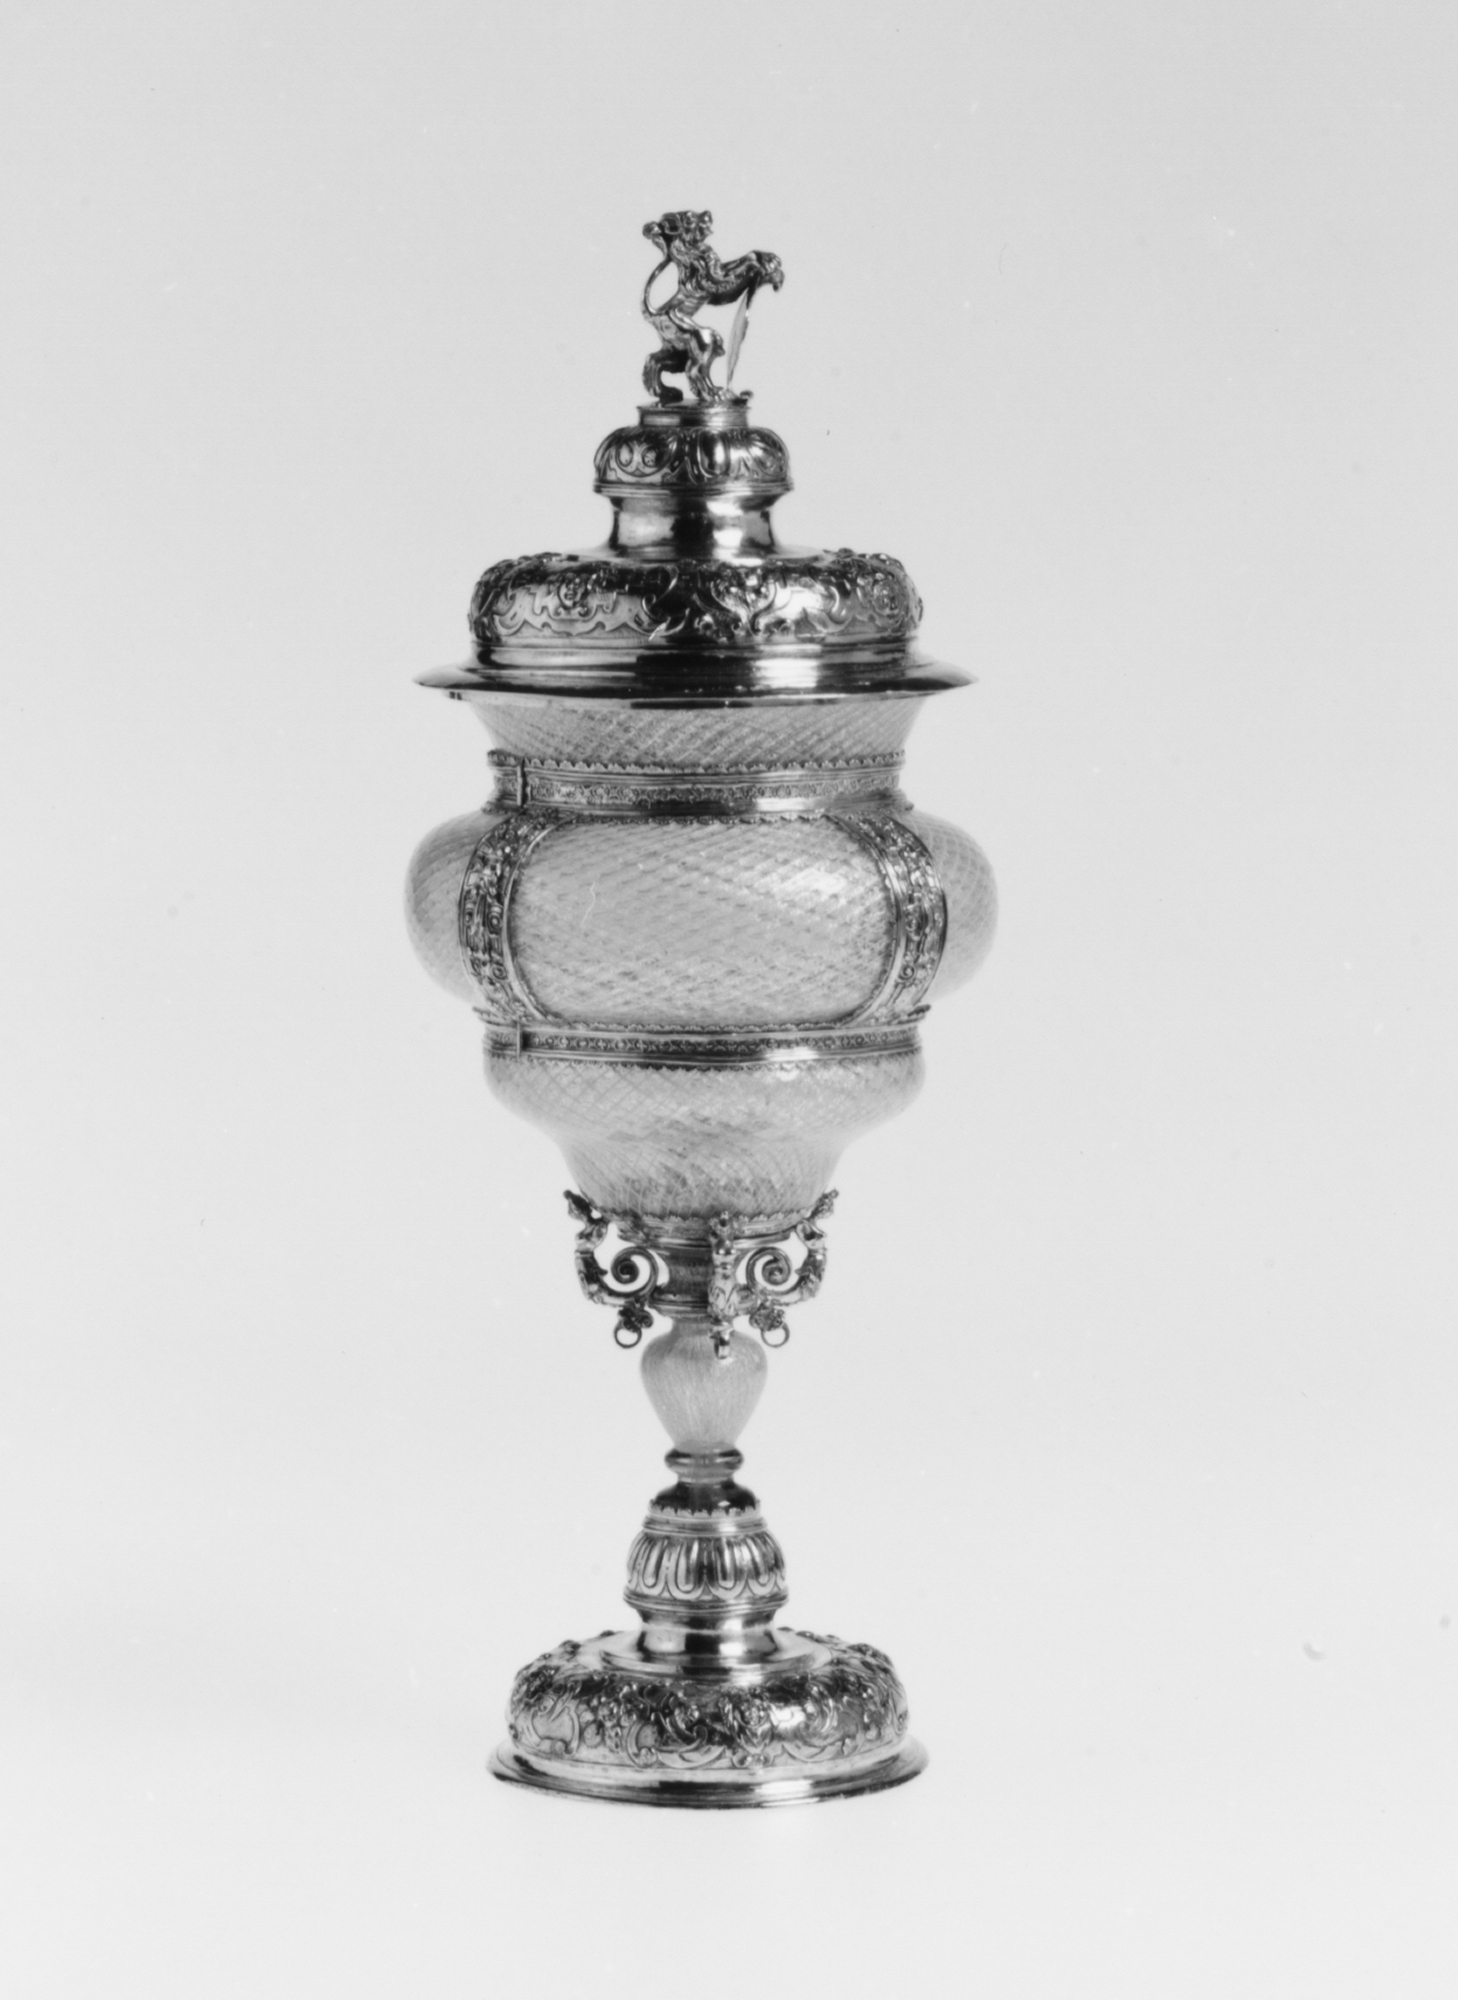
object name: goblet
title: Covered goblet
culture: italian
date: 1534-1566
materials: foil, glass, silver, silver gilt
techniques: glassblowing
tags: lions